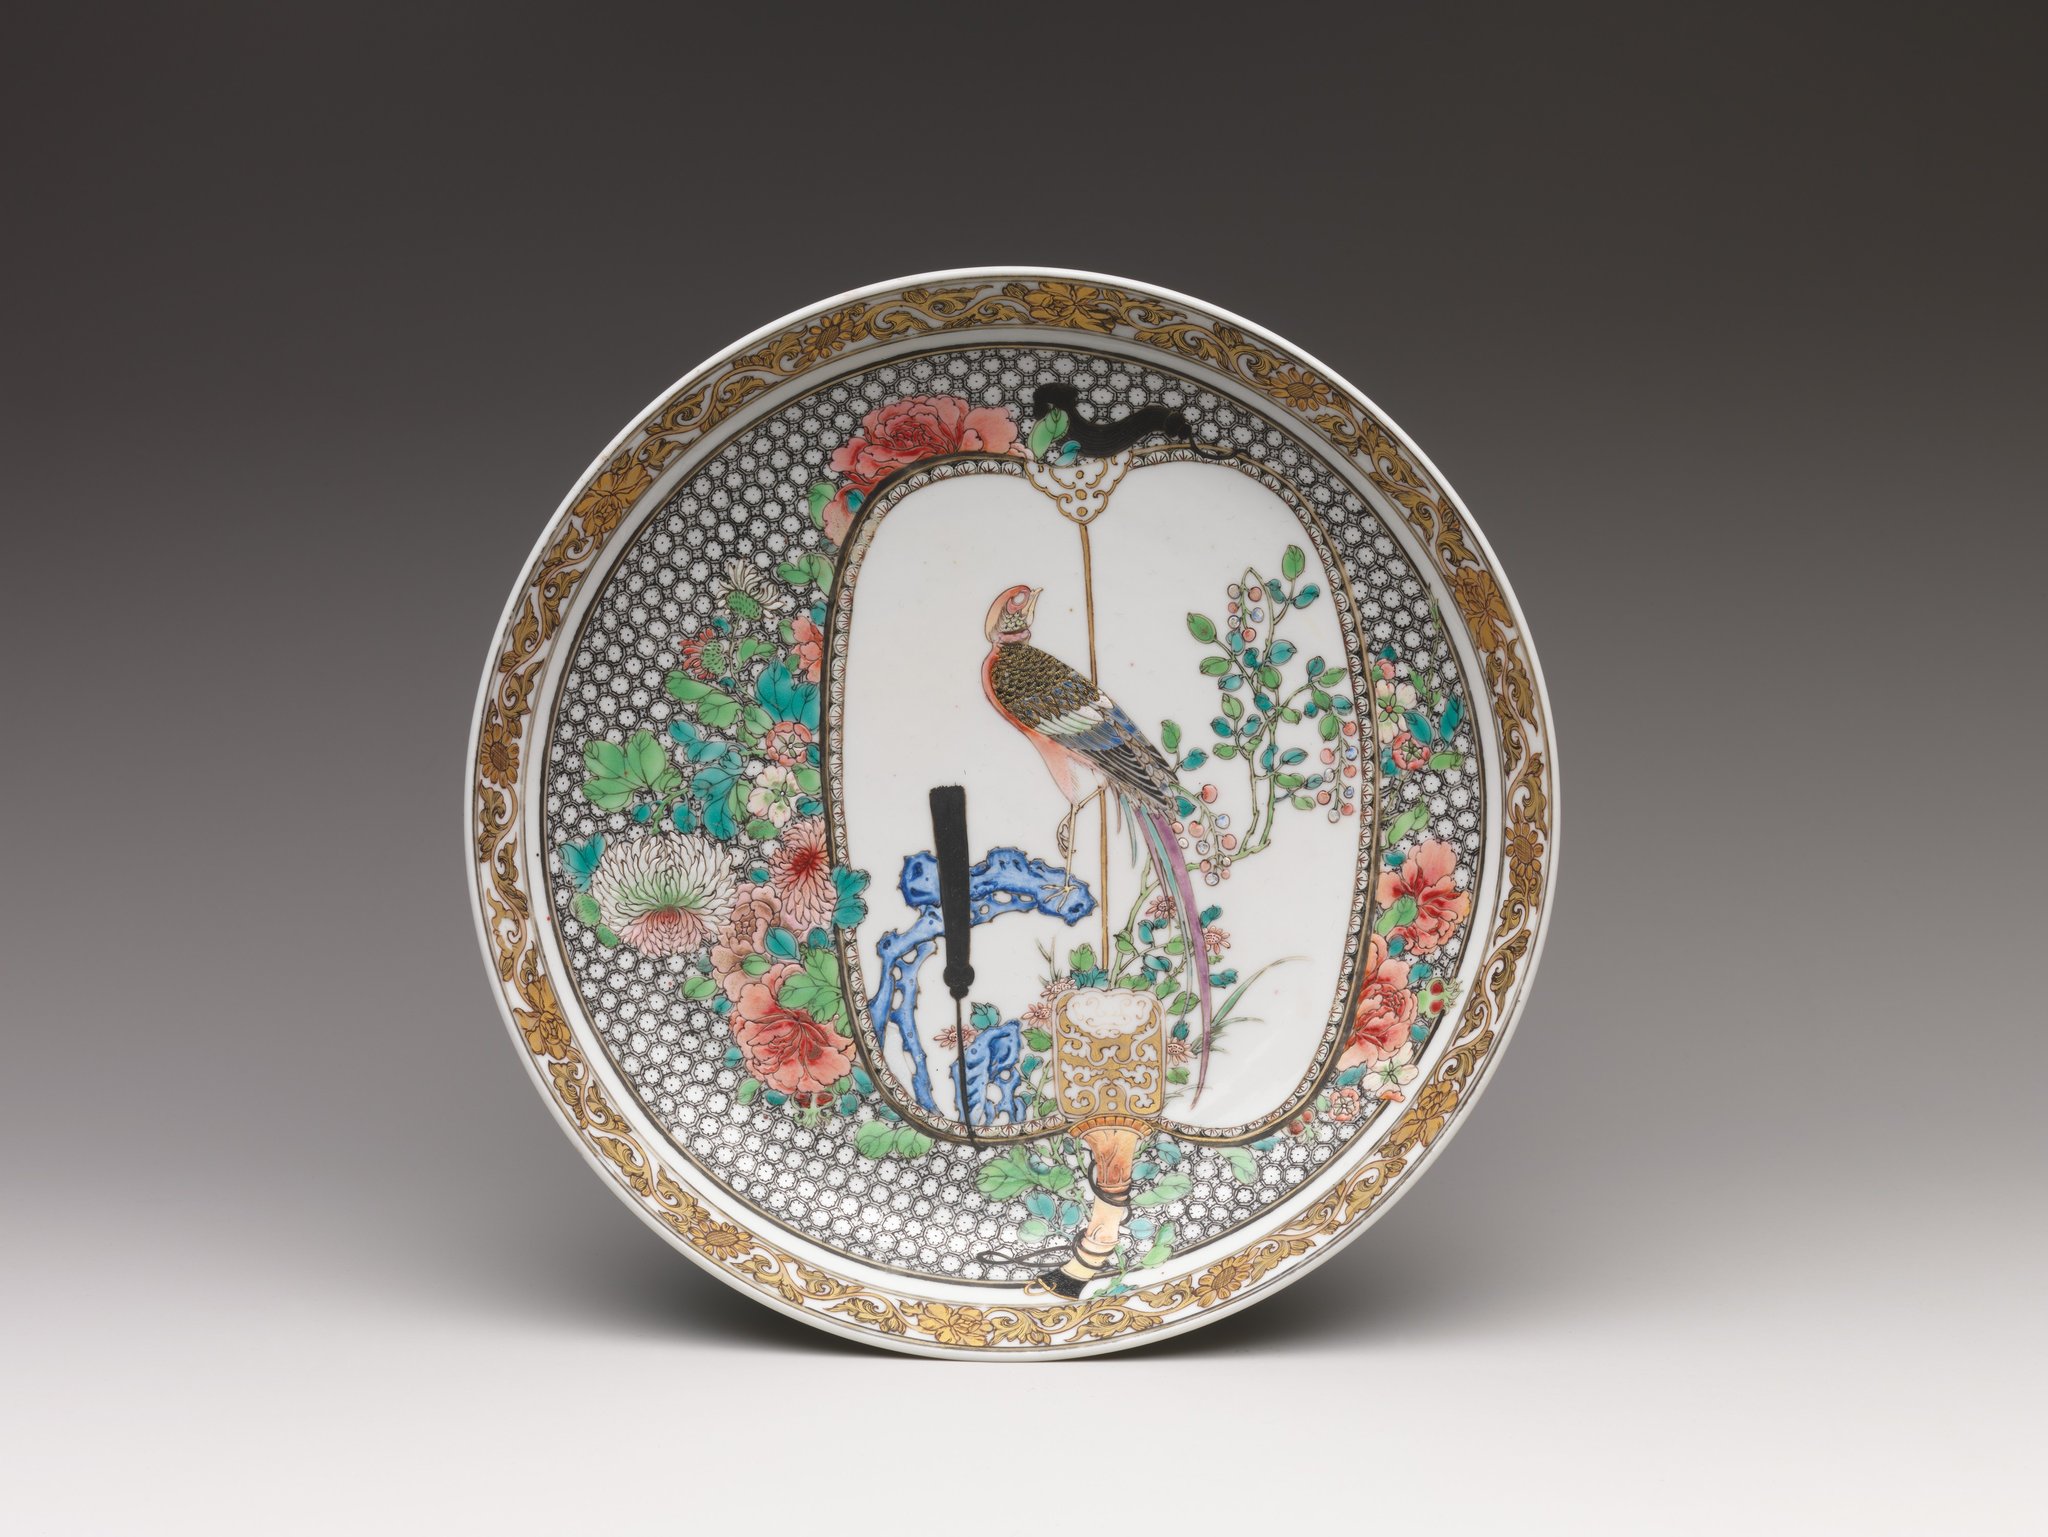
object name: dish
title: Dish with pheasant and flowers on fan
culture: chinese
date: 1730-1750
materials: enamel, gold, porcelain, silver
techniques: overglaze, painting, polychrome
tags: birds,fans,flowers